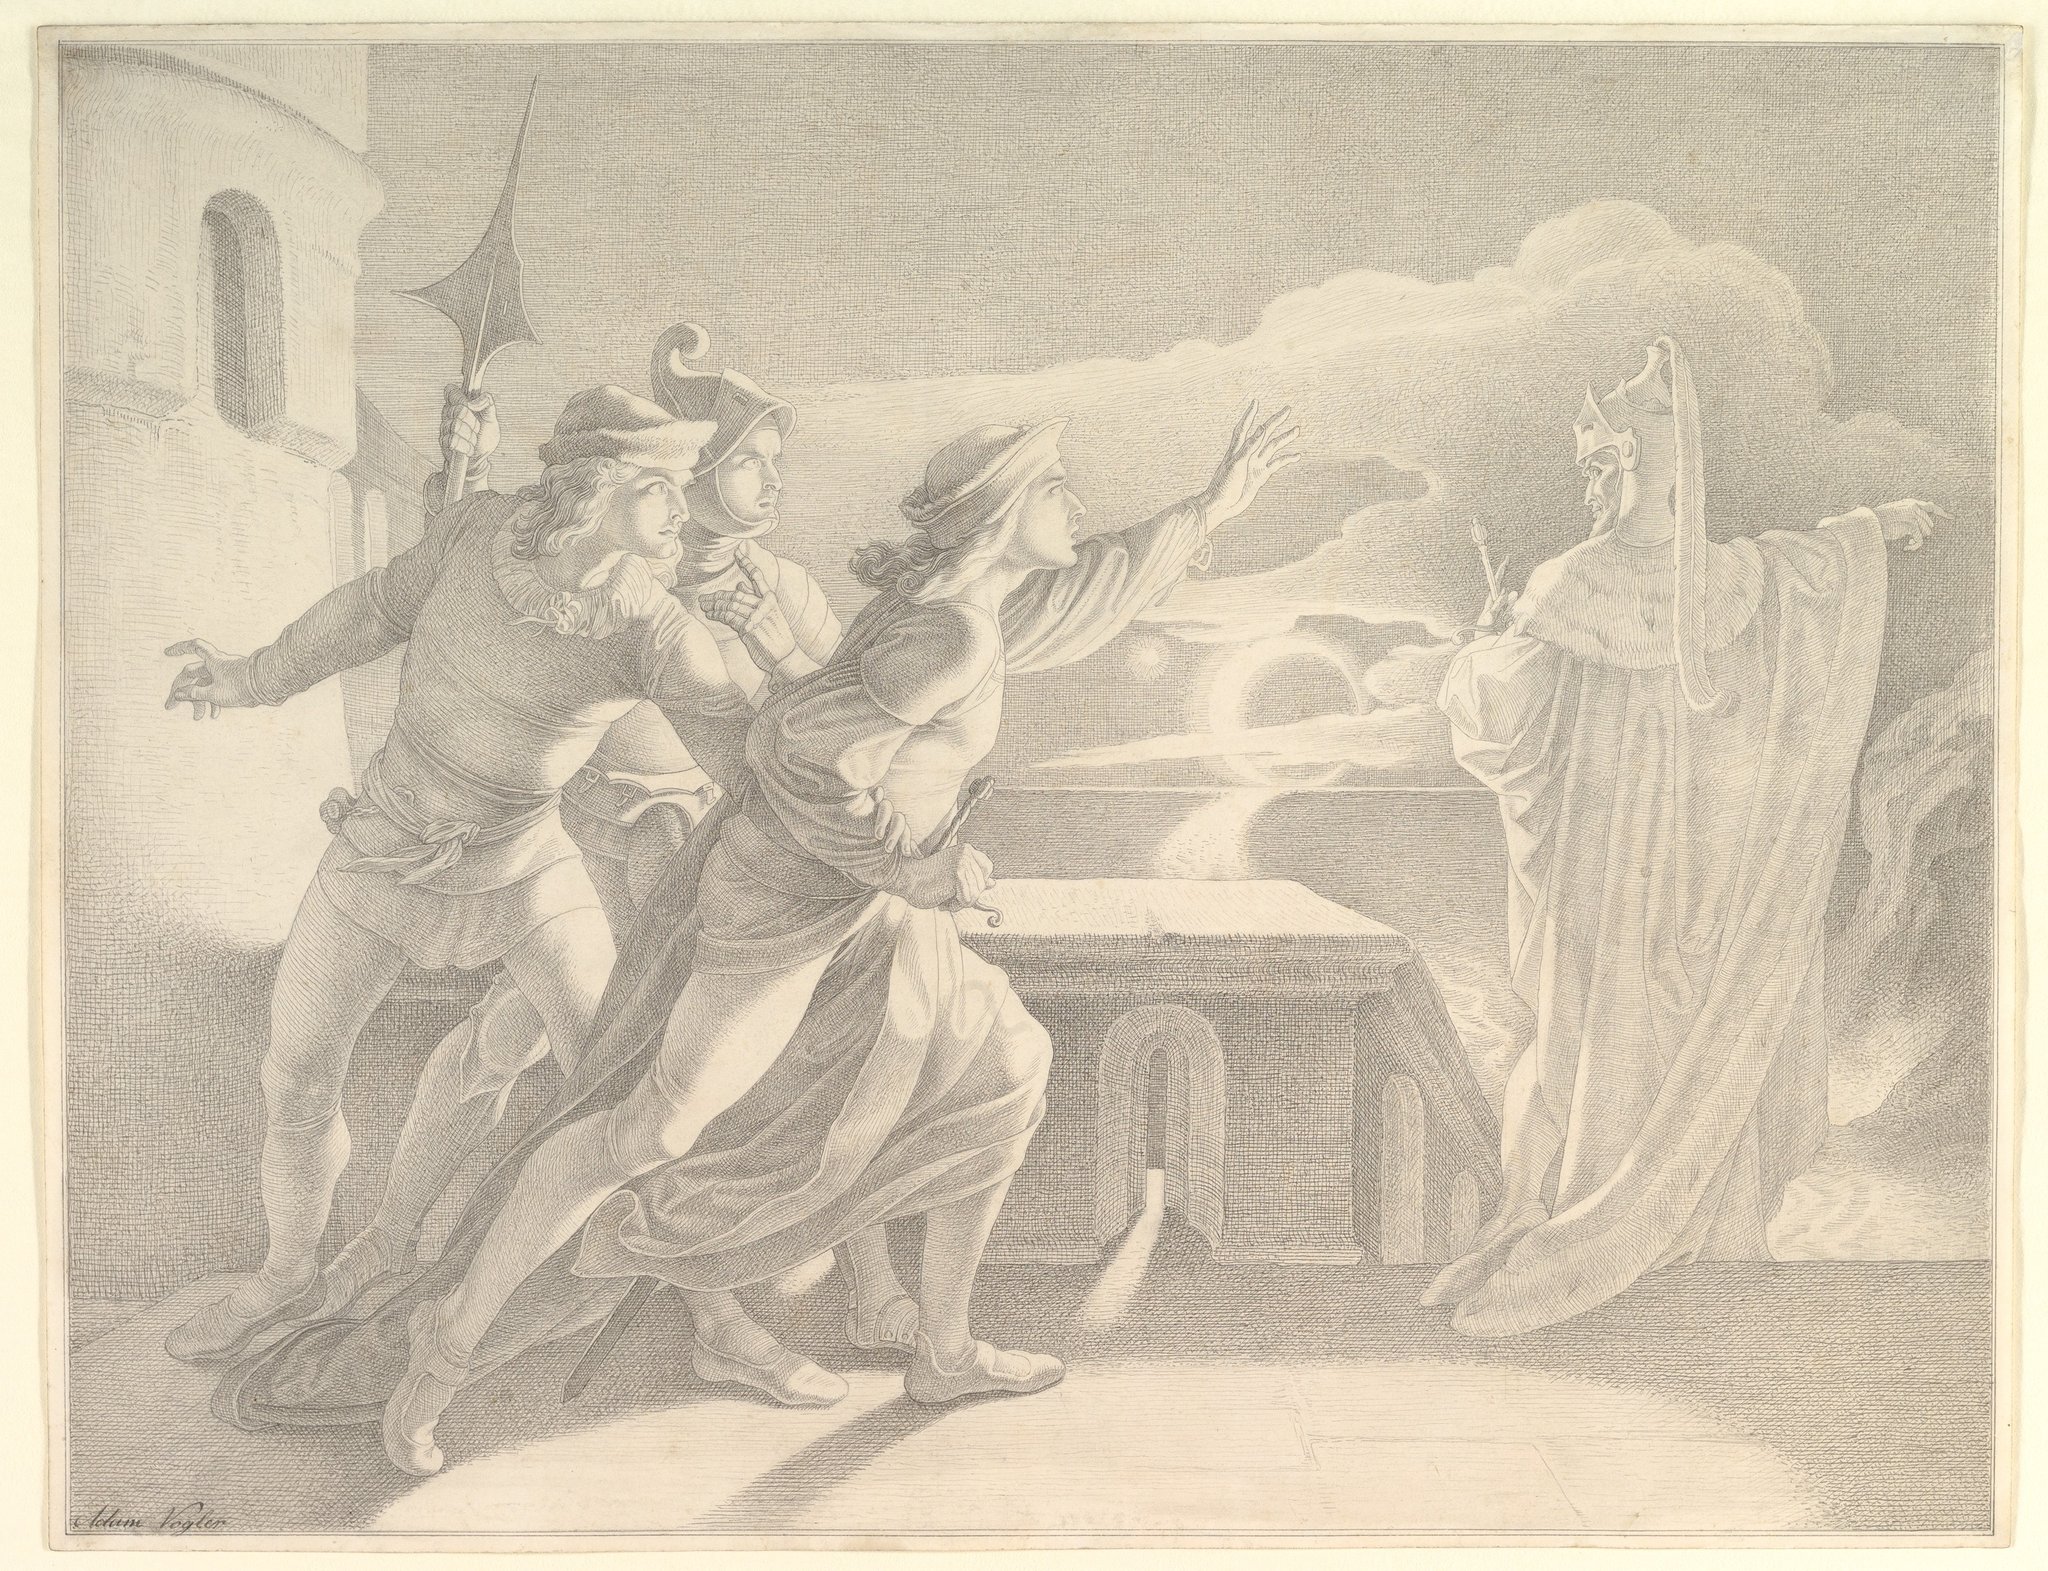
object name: drawing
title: Hamlet and the Ghost of his Father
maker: adam vogler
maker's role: artist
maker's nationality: austrian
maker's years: 1822-1856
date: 1834-1866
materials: graphite, ink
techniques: pen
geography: austria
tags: shakespeare,men,hamlet